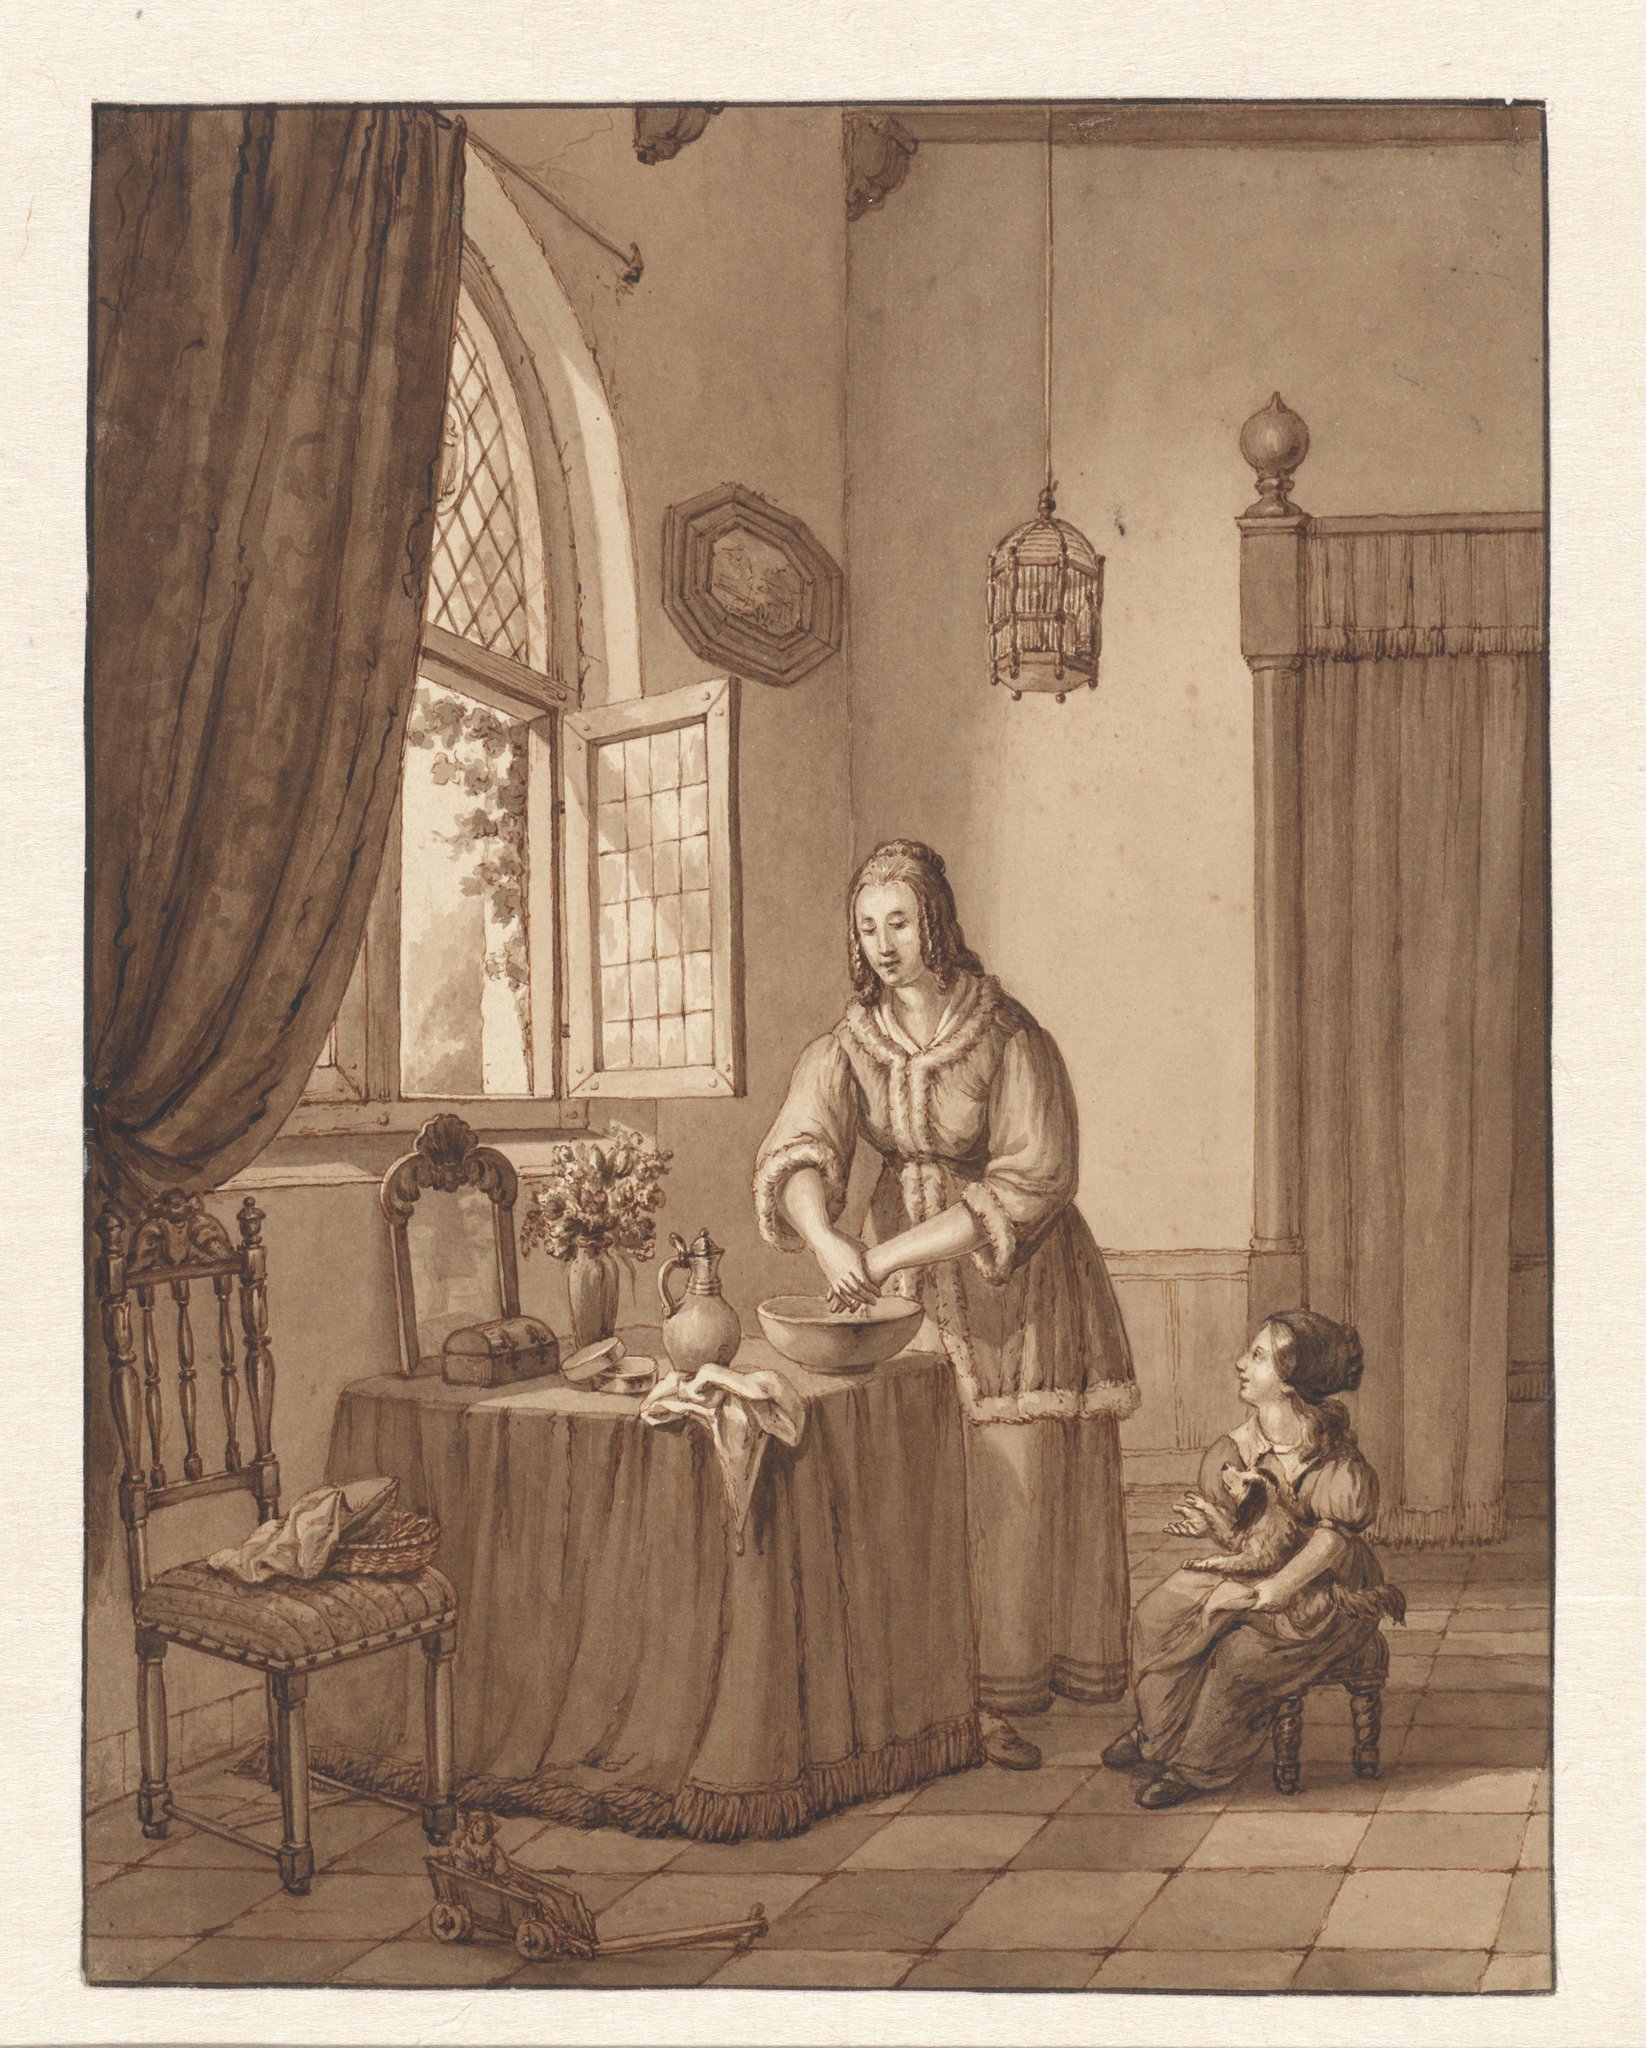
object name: drawing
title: Interieur met een vrouw en een meisje met een hond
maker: johan philip van der kellen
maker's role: draughtsman, print maker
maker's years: 1831-1906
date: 1841-1906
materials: ink, paper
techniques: brush, pen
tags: female sex; woman, girl (child between toddler and youth), interior of the house, washing one's hands, dog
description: Interieur met een handen wassende vrouw en een meisje met een hond op schoot.